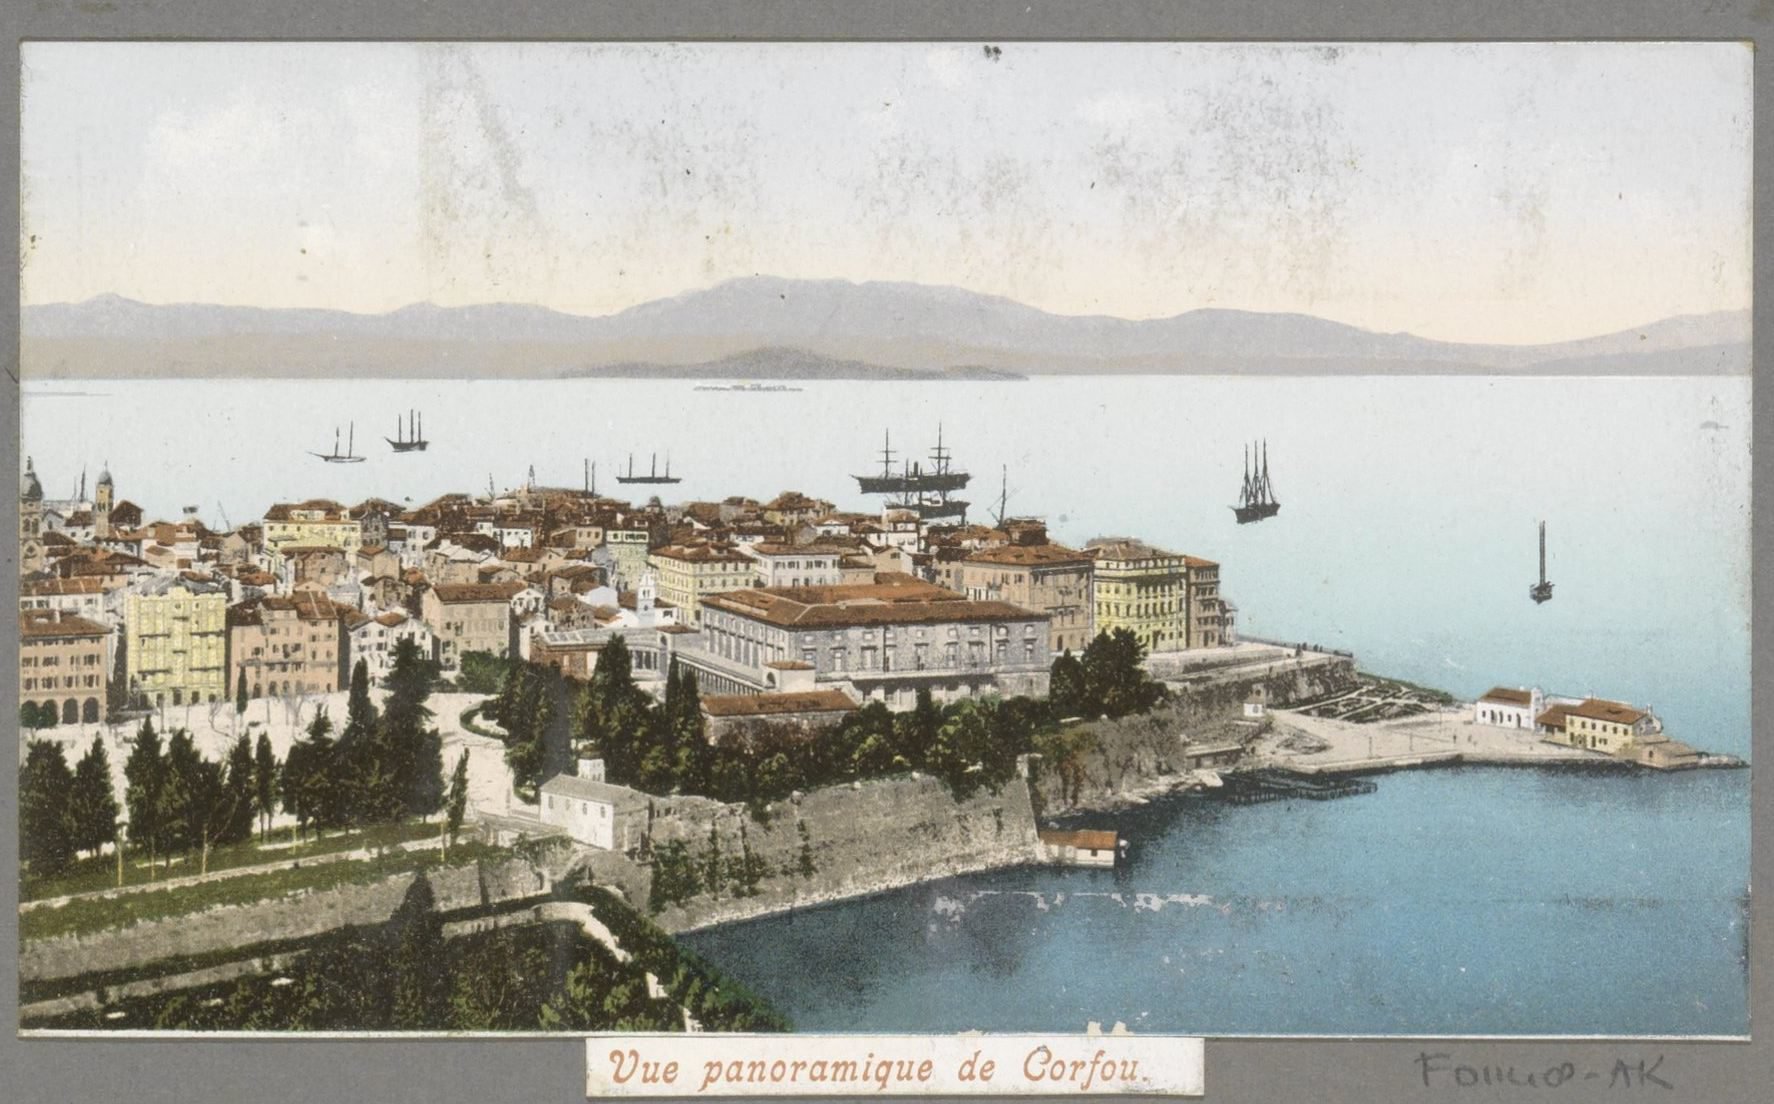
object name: ansichtkaart, prentbriefkaart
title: Gezicht op de stad Corfu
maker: Anonymous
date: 1895-1905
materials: paper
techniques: lithograph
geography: corfu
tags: prospect of village, silhouette of village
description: Onderdeel van Reisalbum met foto's van bezienswaardigheden in Griekenland en Egypte.